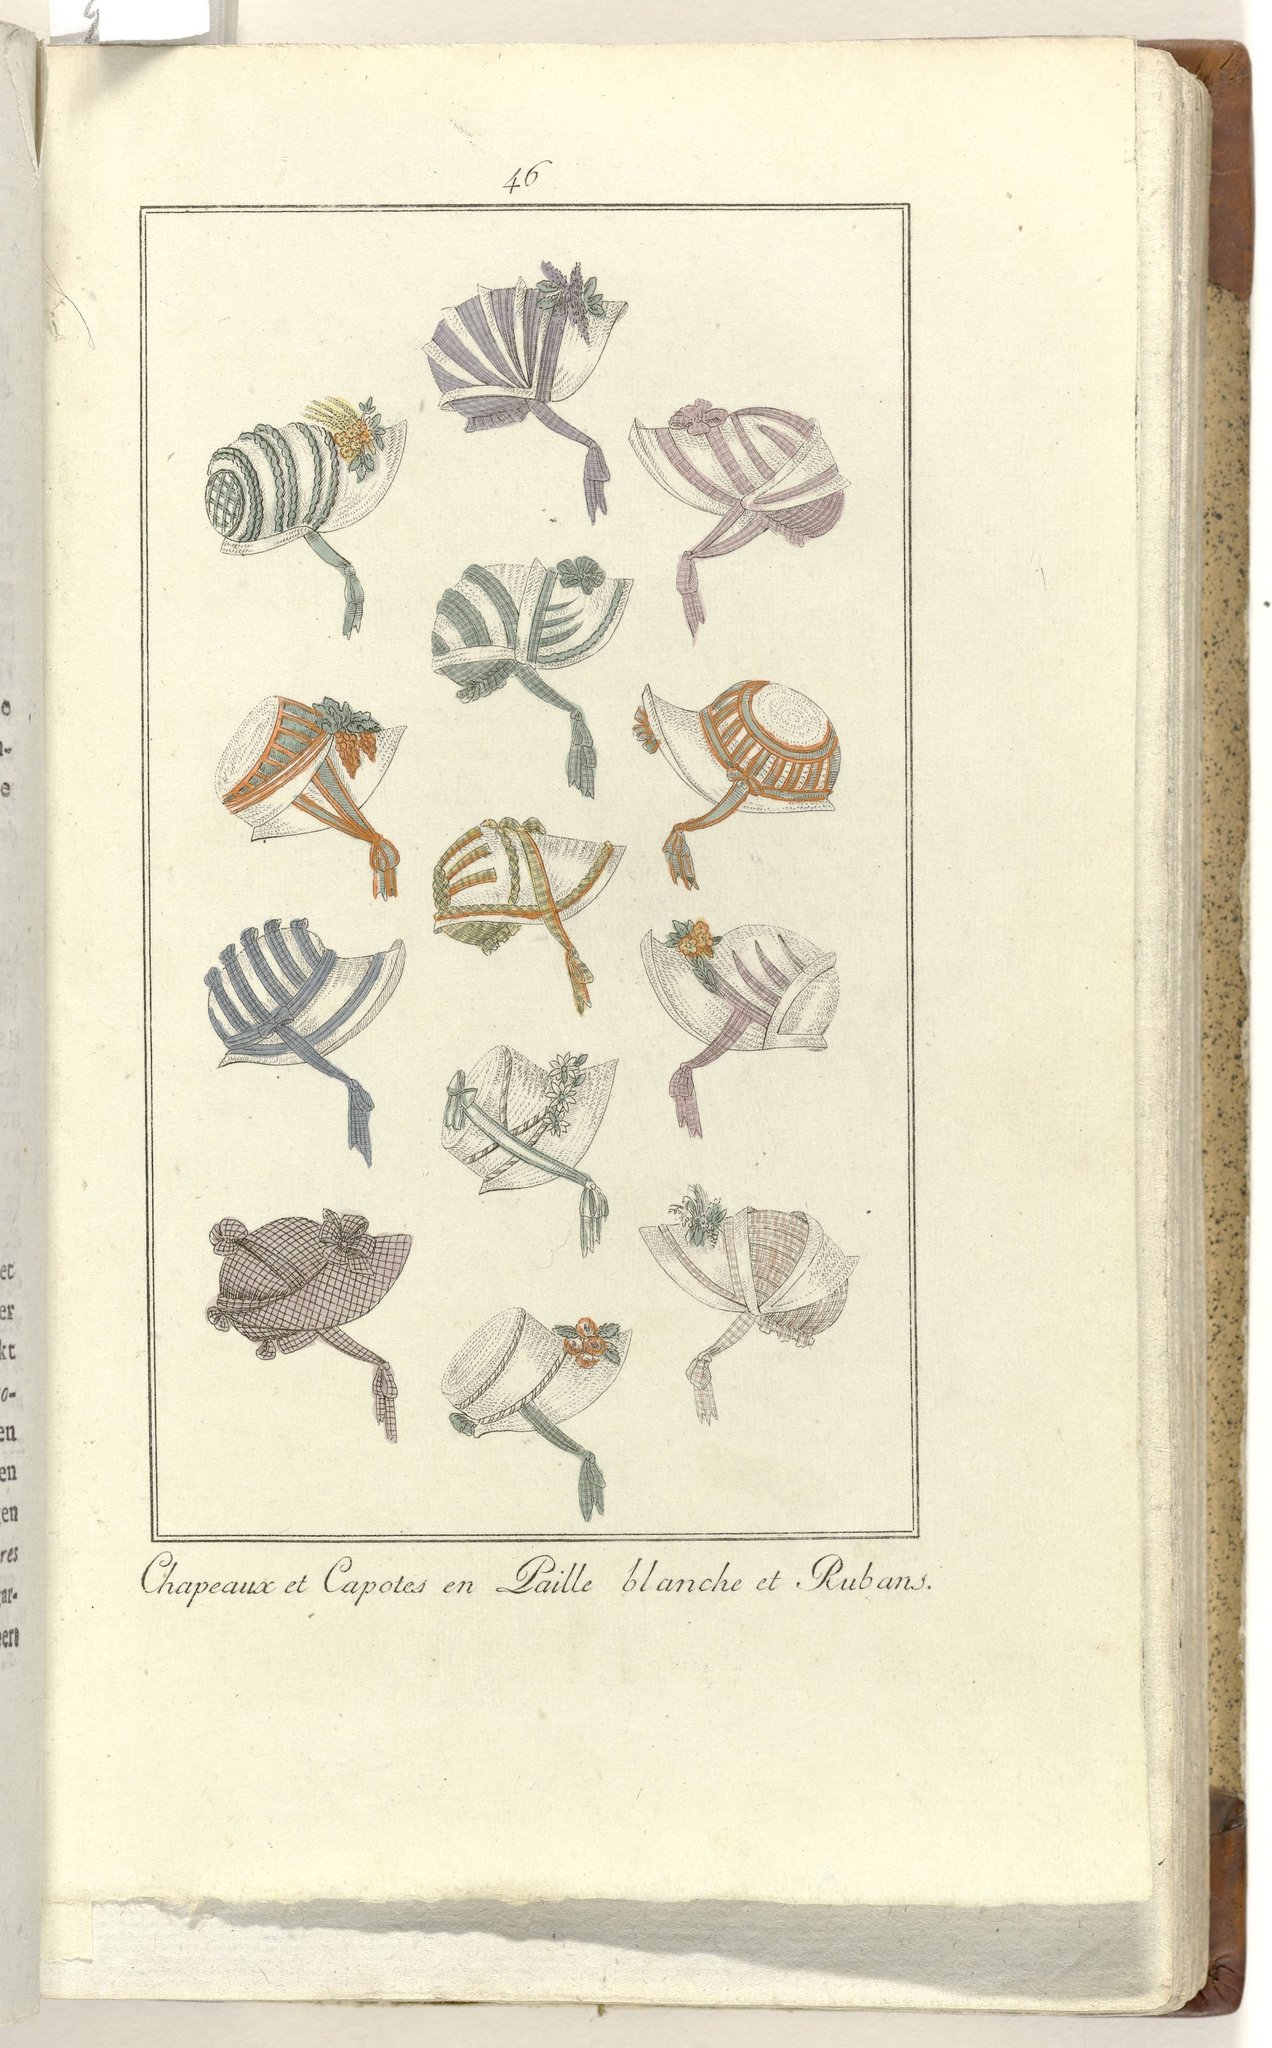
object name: fashion print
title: Elegantia, of tijdschrift van mode, luxe en smaak voor dames, Juni 1808, No. 46: Chapeaux et Capotes...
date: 1808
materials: paper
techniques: engraving, hand coloring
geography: amsterdam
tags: head-gear (capote) (+ women's clothes), border, ribbon, braid (+ women's clothes), fashion plates, head-gear: hat (+ women's clothes)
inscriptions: caption: ‘Chapeaux et Capotes en Paille blanche et Rubans.’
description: Volgens de begeleidende tekst (p. 192): Dertien modellen van verschillende hoeden en capotes van wit stro met linten, 'naar den nieuwsten smaak'. Prent uit het modetijdschrift Elegantia, of tijdschrift van mode, luxe en smaak voor dames 1807-1814 (onderbroken door de periode 1811-1813).